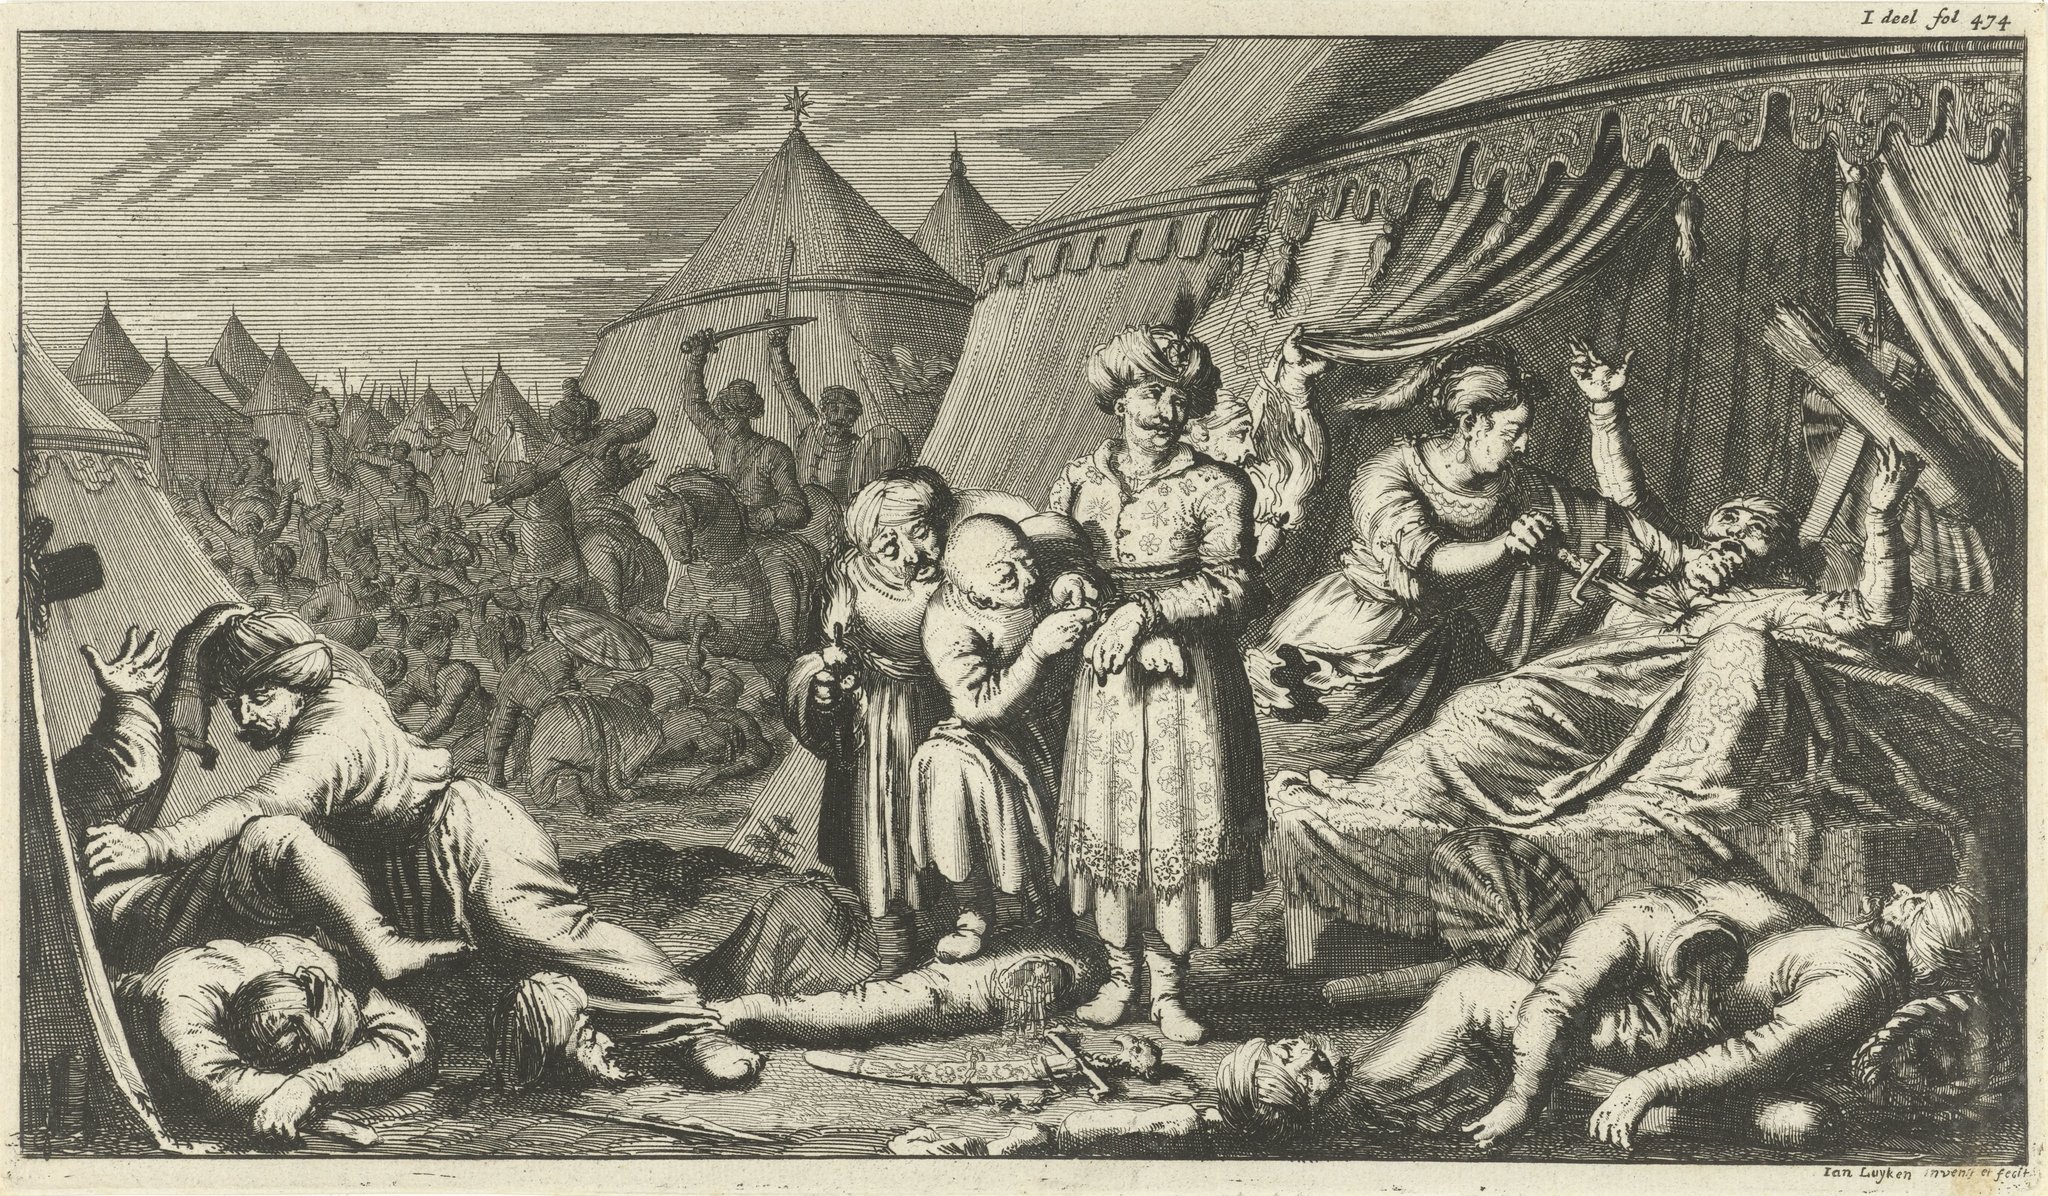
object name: book illustration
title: De Kan van Ormus overvallen en gedood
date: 1682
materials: paper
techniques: etching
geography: amsterdam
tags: (military) camp with tents, violent death, being killed; being mishandled and maltreated; seeking death, ruler, sovereign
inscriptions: collector's mark: Lugt 2228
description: Illustratie opgenomen in: Tavernier, Jean Baptiste. De Zes Reizen, 3 delen. Amsterdam: weduwe Joannes van Someren, 1682, dl. 1.